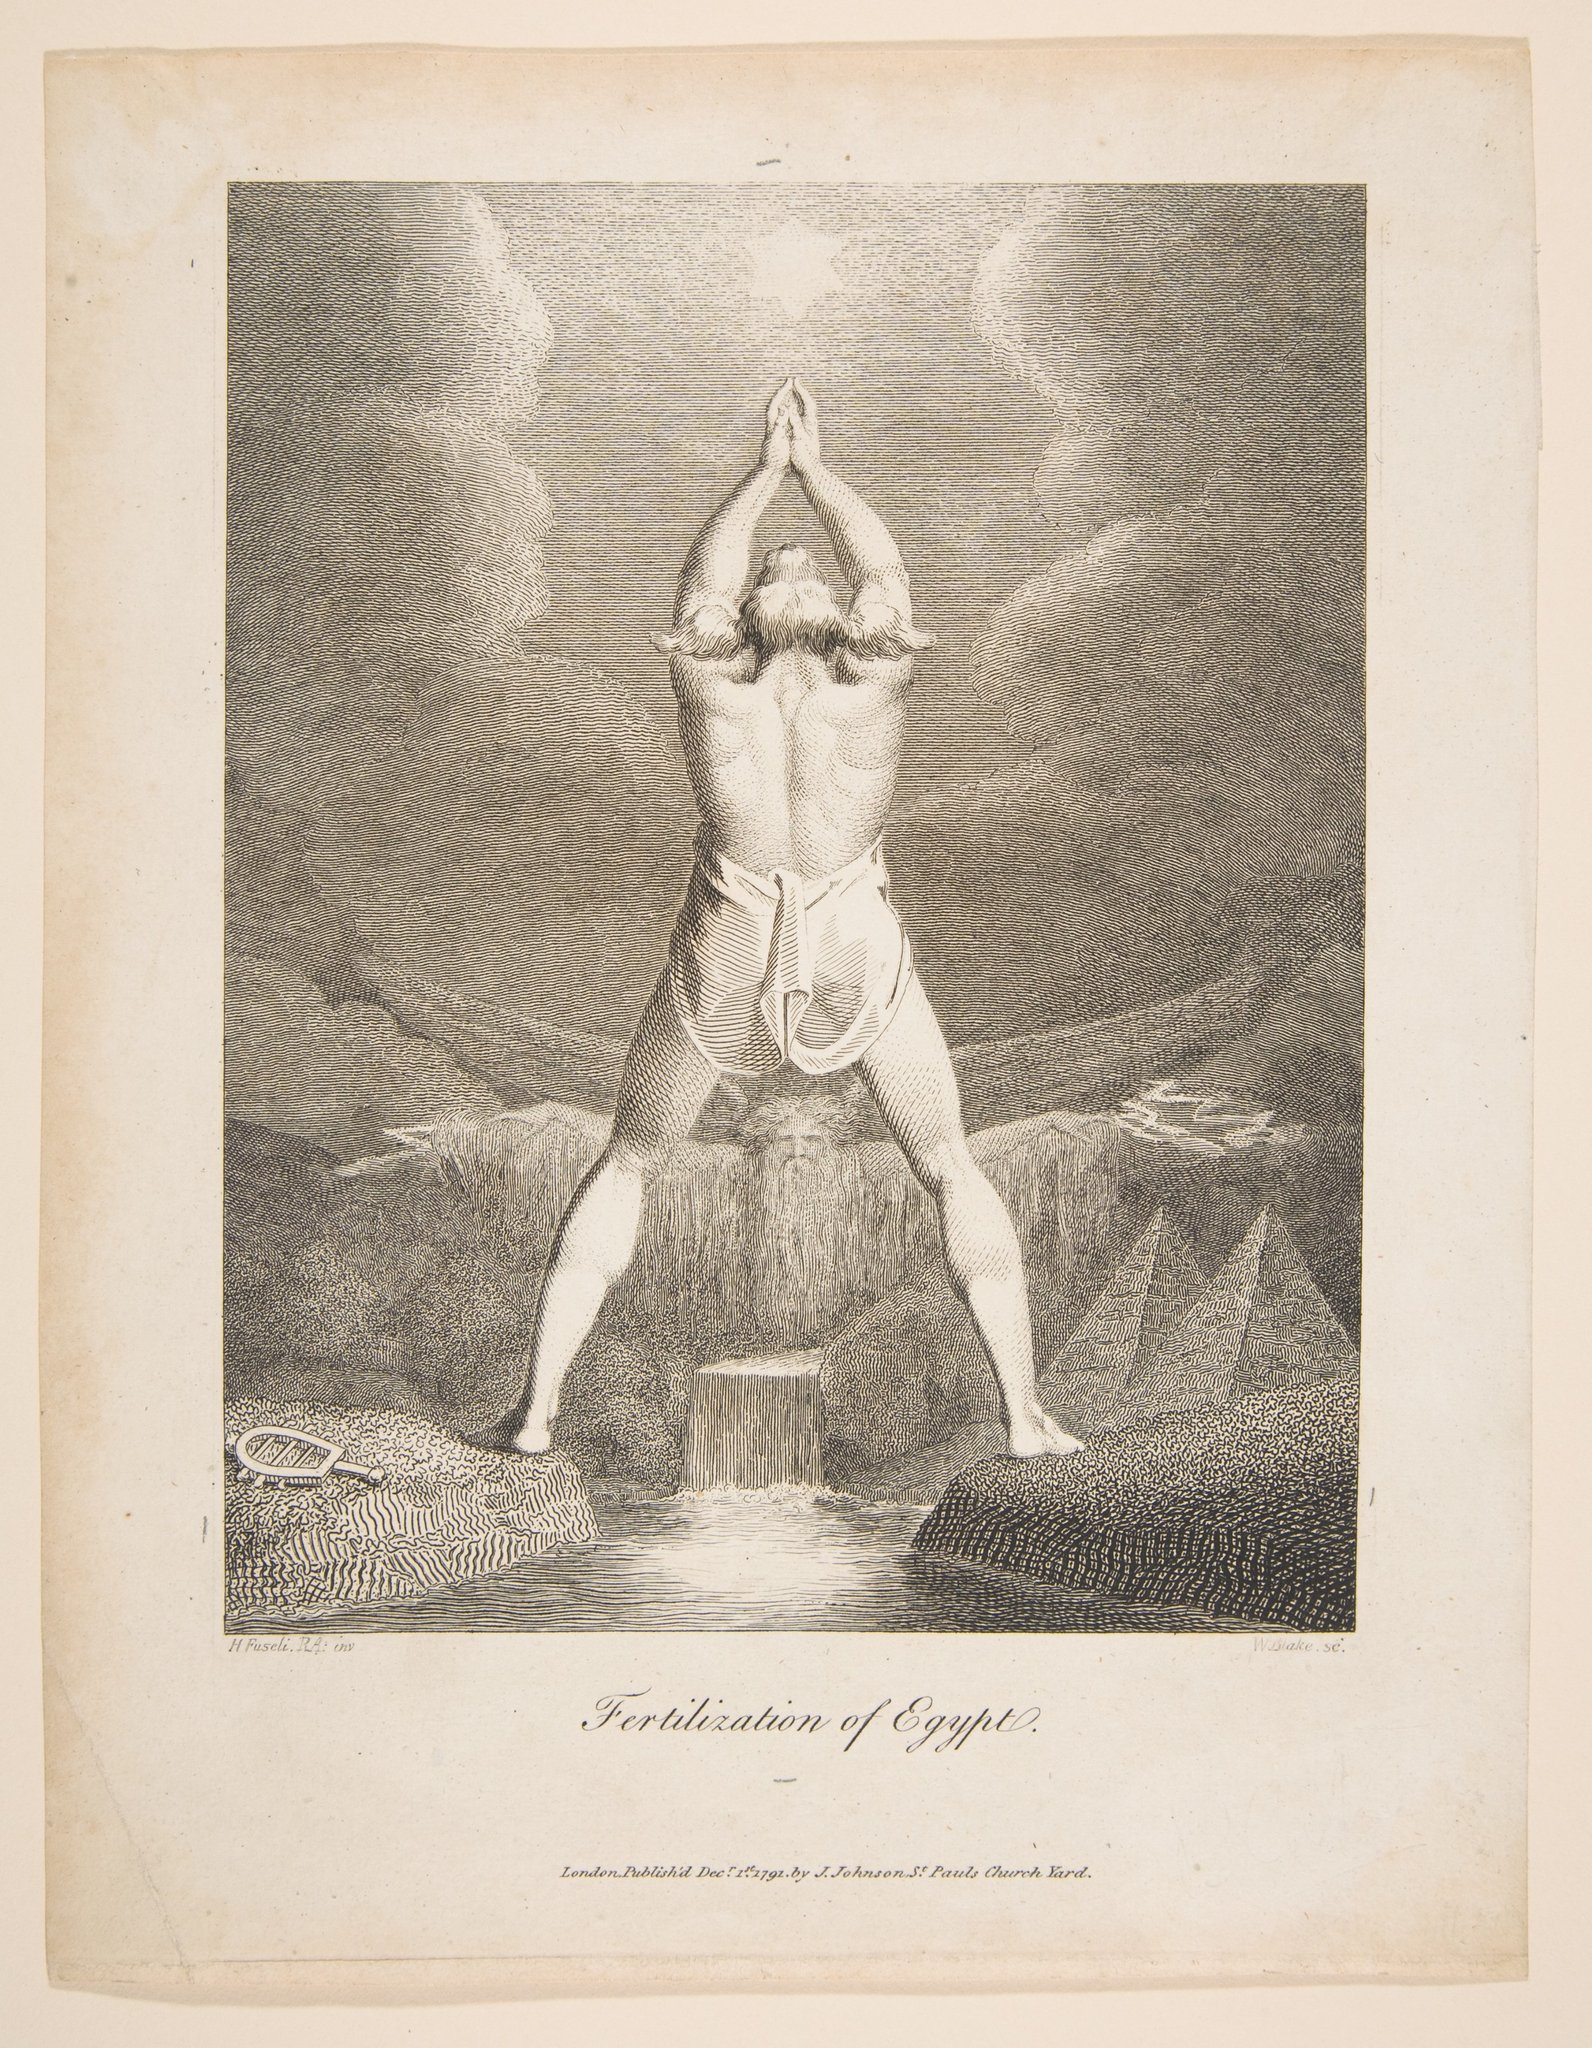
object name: print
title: Fertilization of Egypt, from Erasmus Darwin's "The Botanic Garden"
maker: william blake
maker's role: artist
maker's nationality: british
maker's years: 1757-1827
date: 1791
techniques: engraving